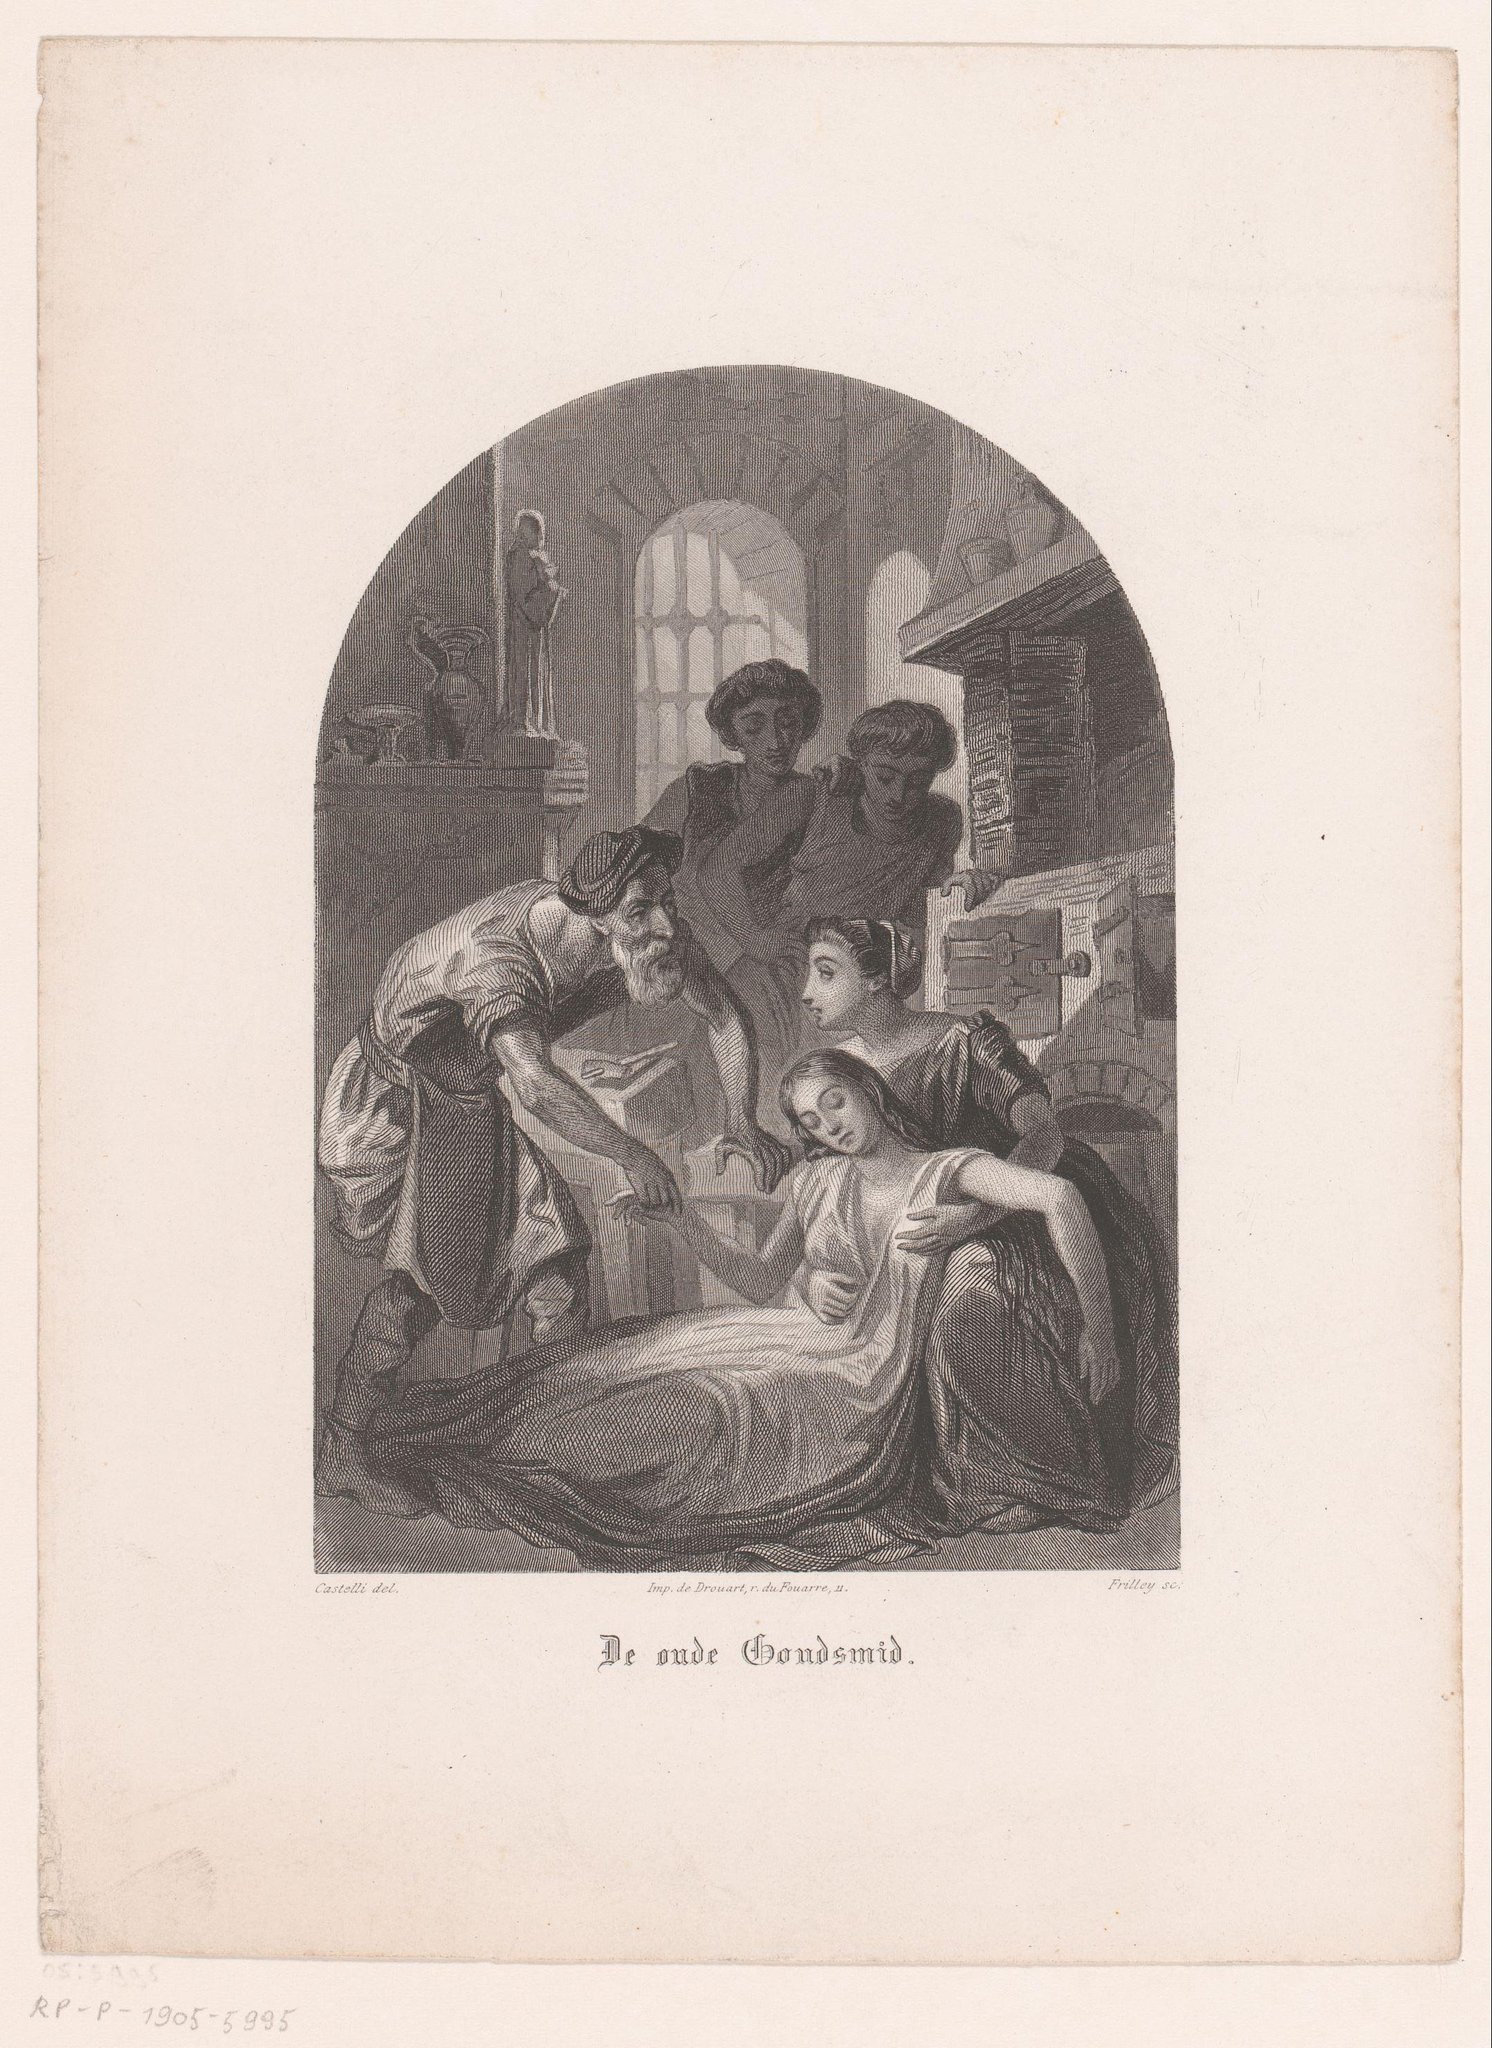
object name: print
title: Flauwvallende vrouw in een werkplaats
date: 1807-1897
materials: paper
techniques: engraving, etching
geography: paris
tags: fainting, swooning, workshop-interior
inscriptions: collector's mark: Lugt 2228